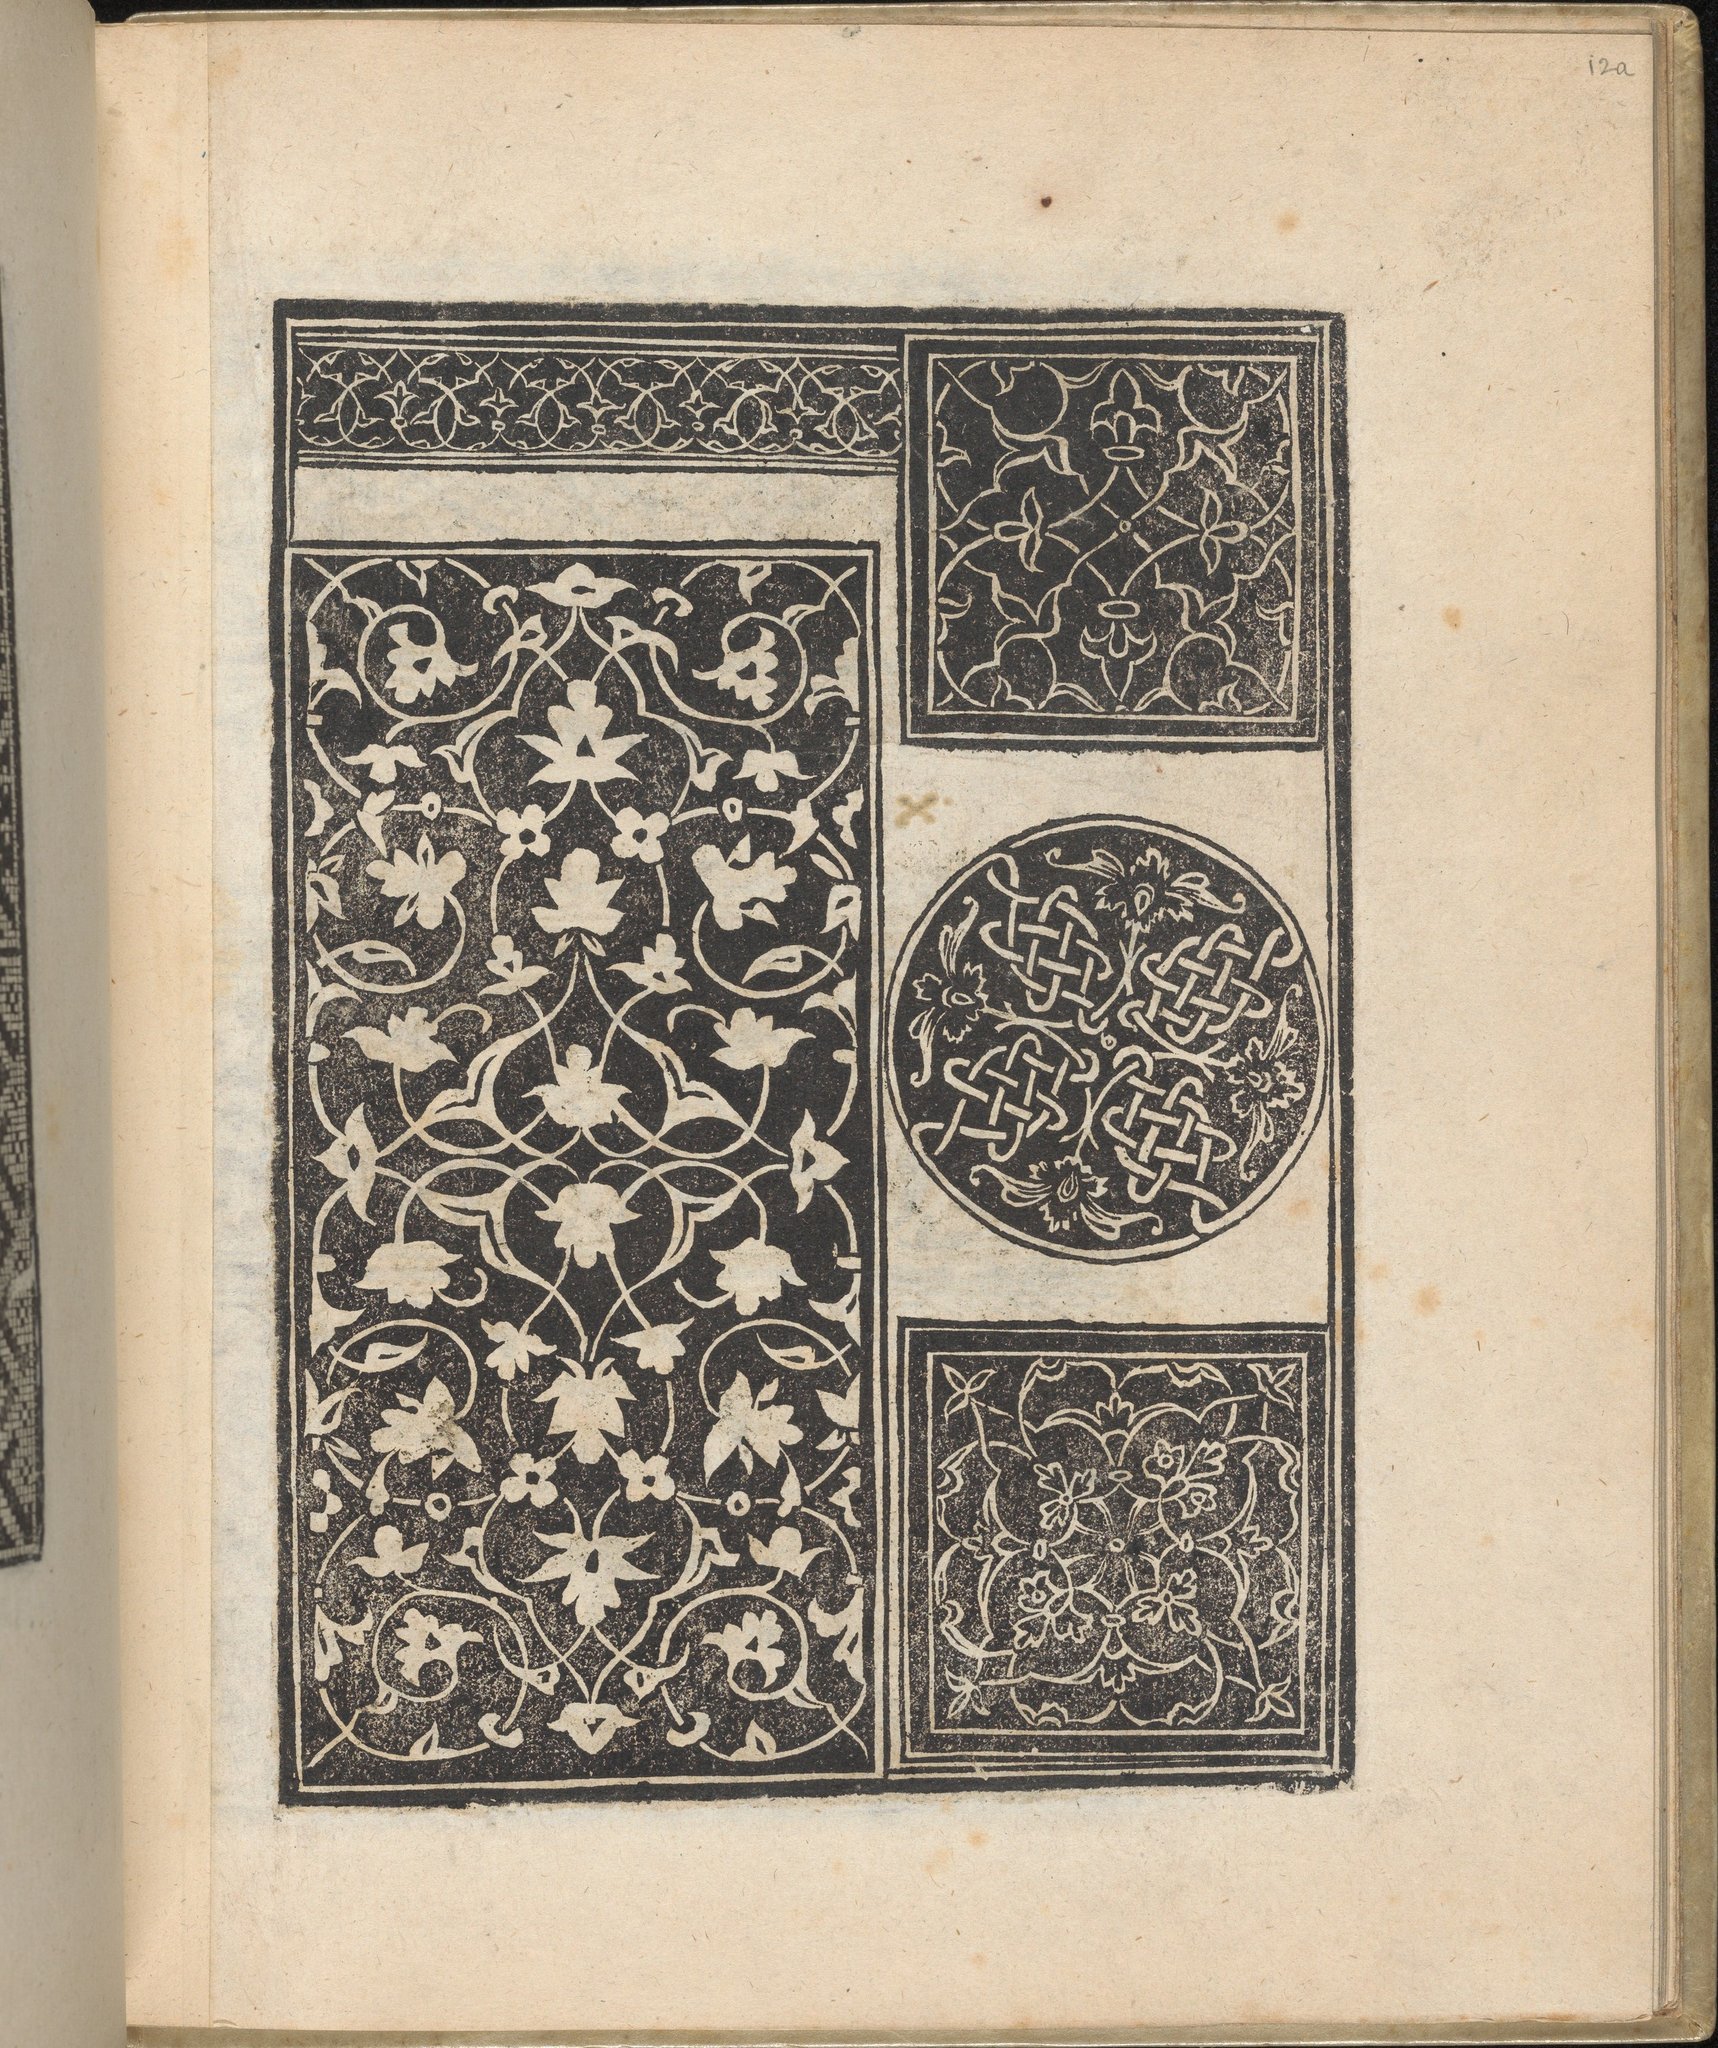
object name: book print ornament architecture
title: Trionfo Di Virtu. Libro Novo..., page 12 (recto)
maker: matteo pagano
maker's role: publisher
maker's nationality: italian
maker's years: 1515-1588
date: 1563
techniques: woodcut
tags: flowers